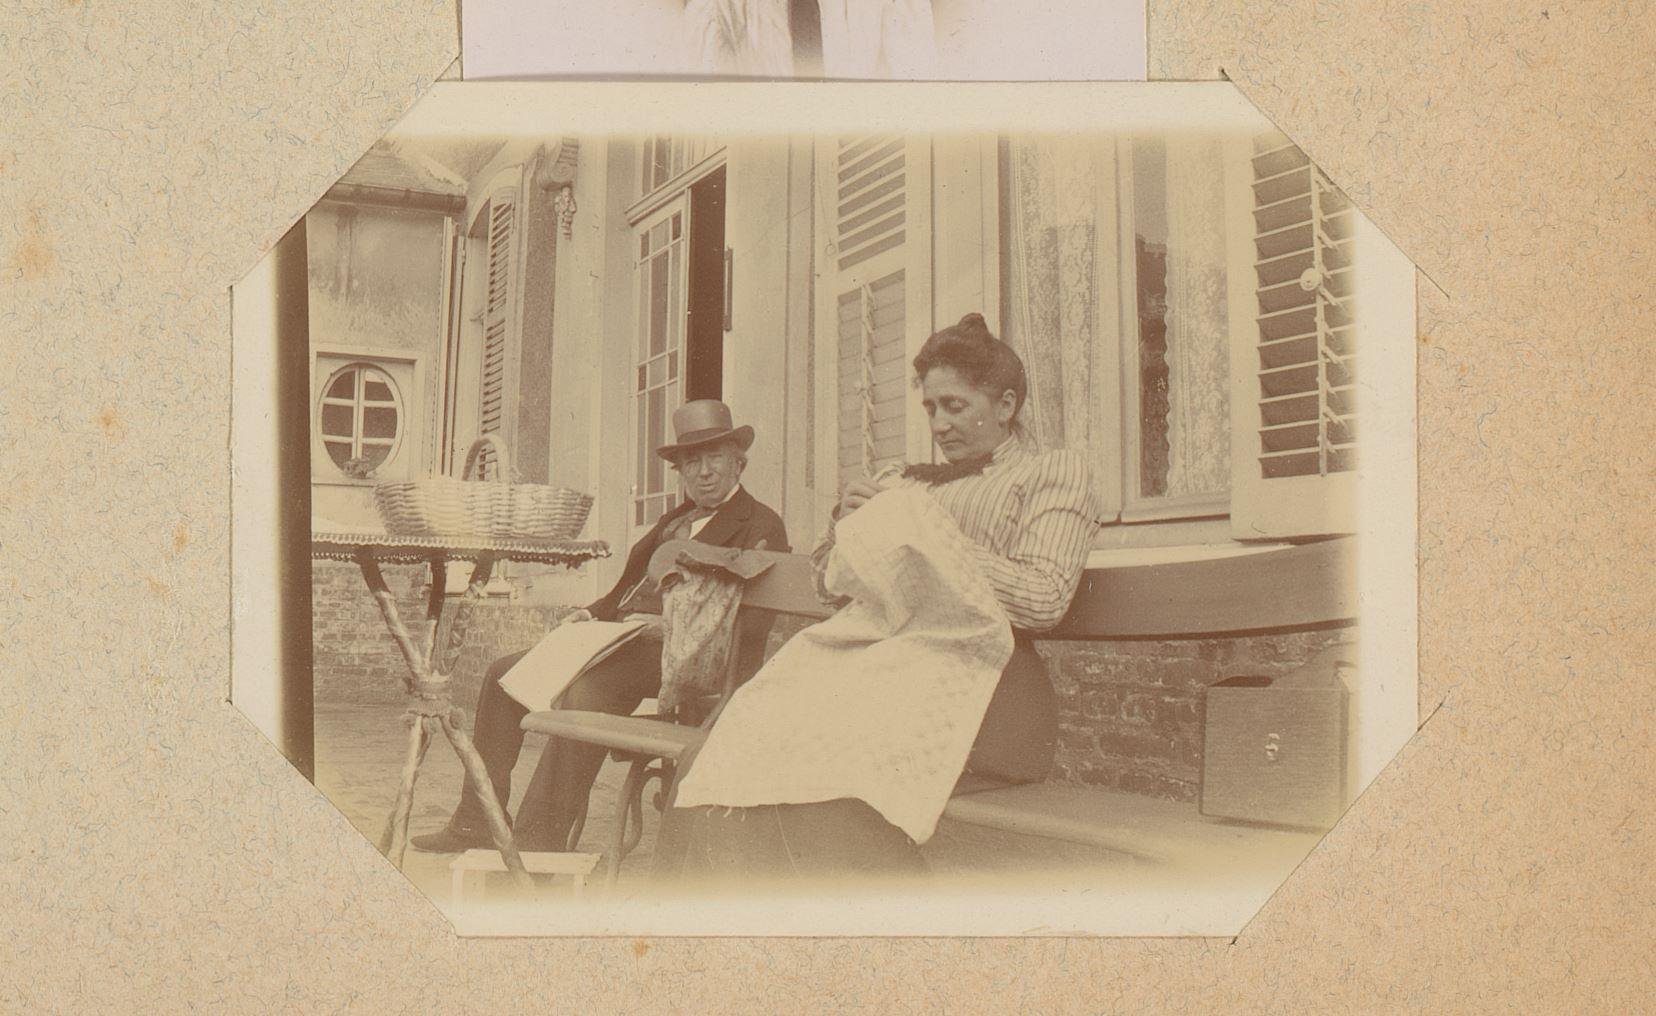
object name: photograph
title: Portret van een man met een krant en een vrouw met handwerk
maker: Anonymous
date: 1897-1900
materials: paper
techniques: gelatin silver print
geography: france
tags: adult woman, adult man, historical persons, (other forms of) needlework, e.g.: crocheting, knitting, embroidering, newspaper, news-sheet, france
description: Over de foto is een ander negatief afgedrukt van een voorstelling van bomen.